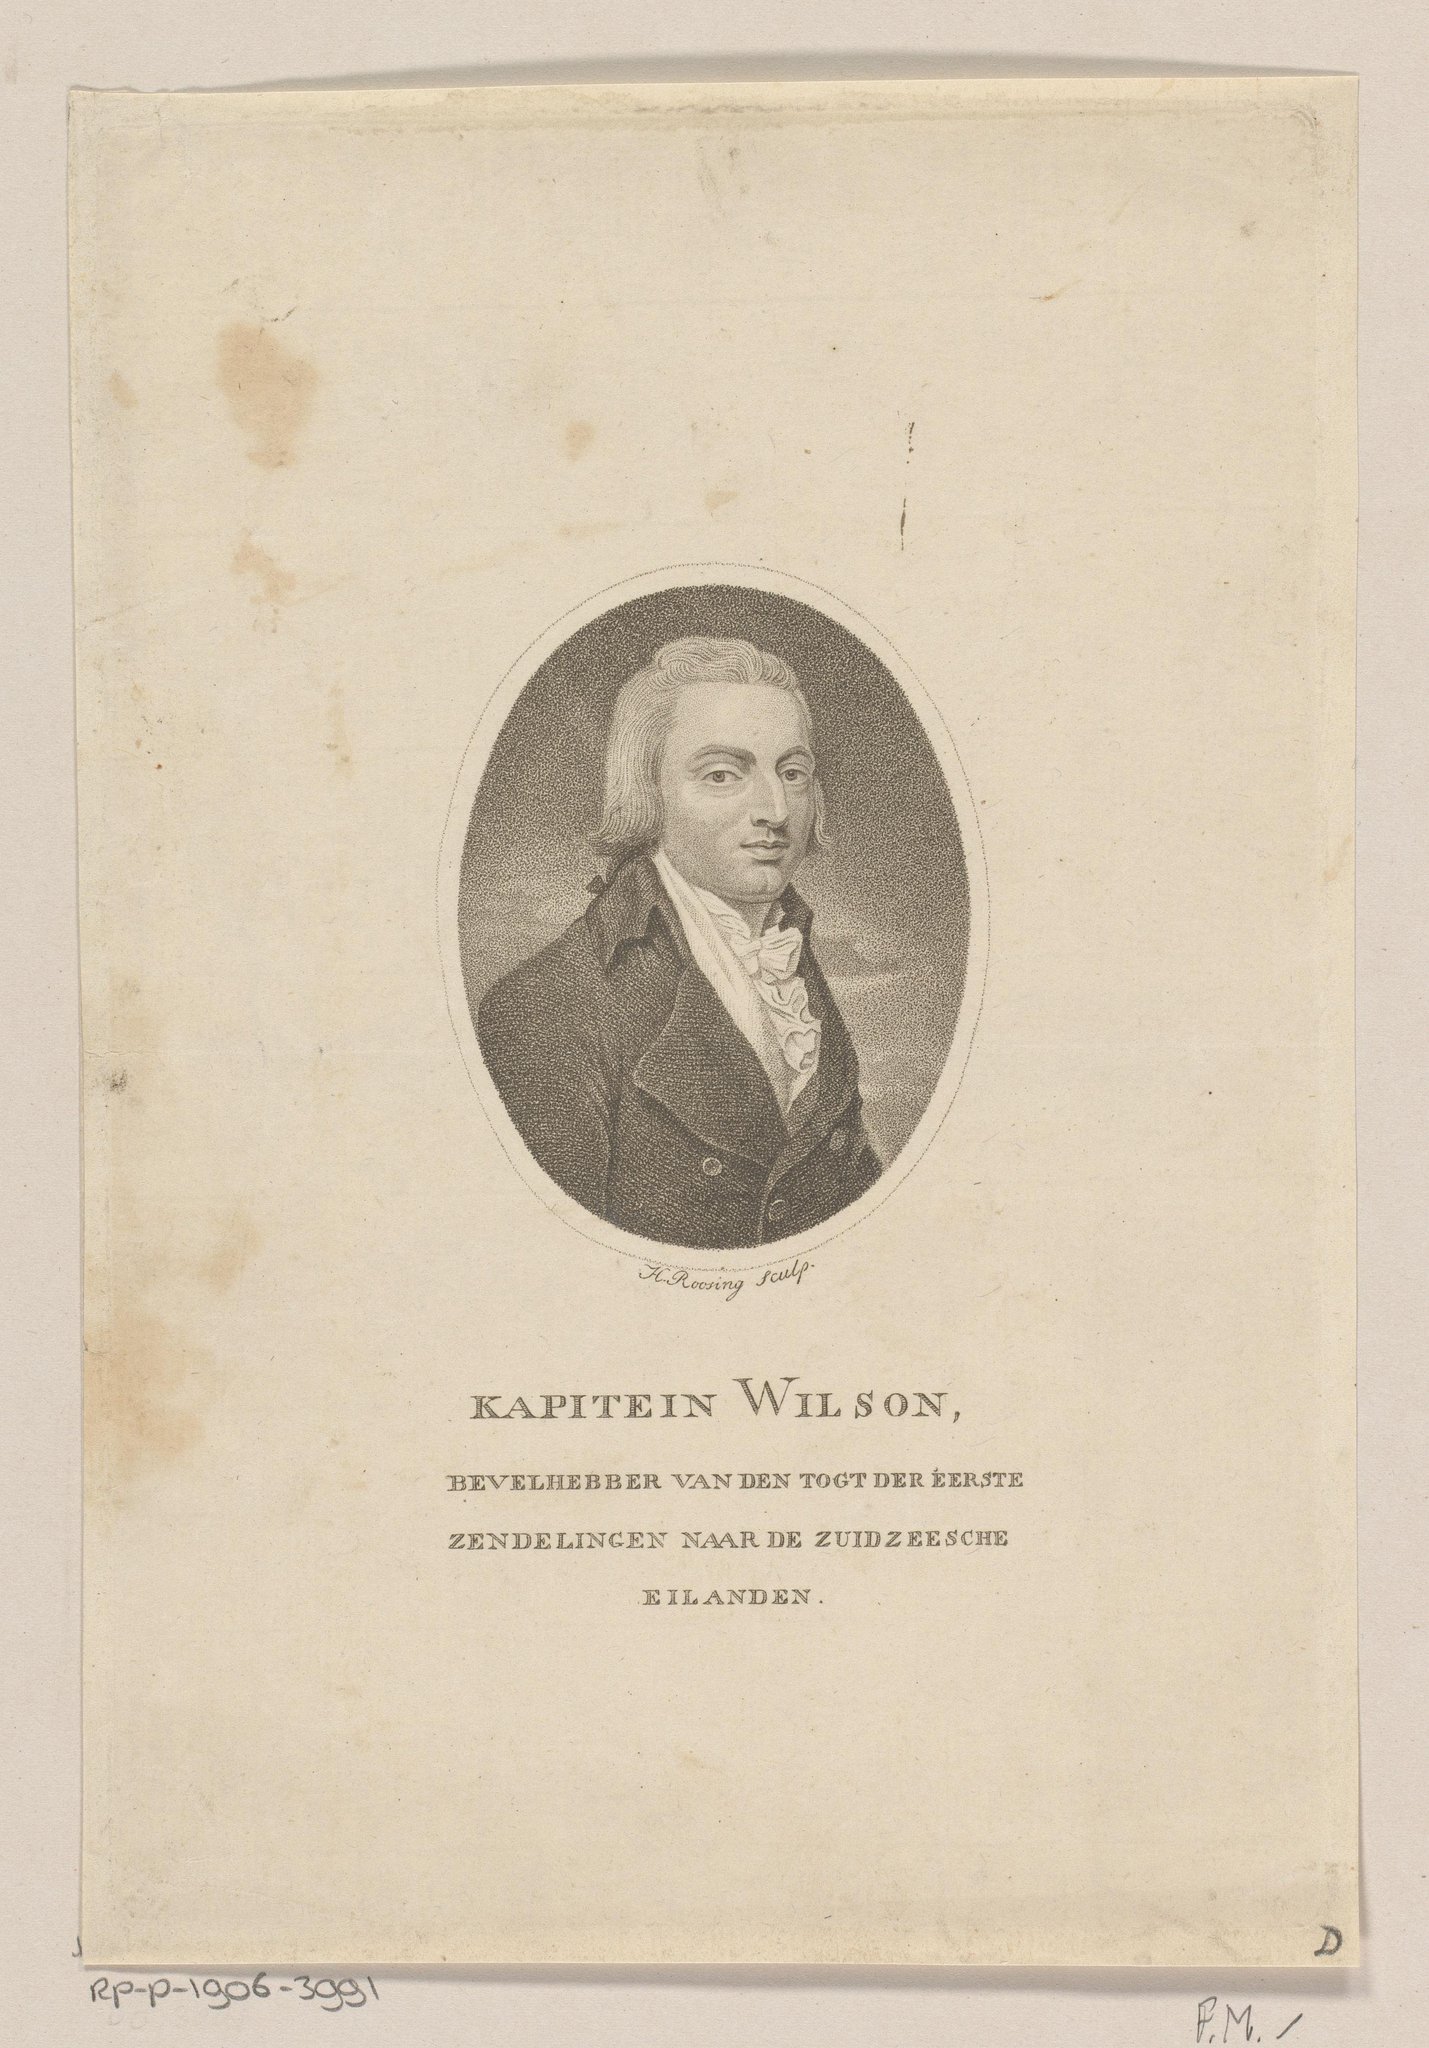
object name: print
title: Portret van Henry Wilson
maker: hendrik roosing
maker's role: print maker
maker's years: 1763-1826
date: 1786-1810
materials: paper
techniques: stippling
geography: rotterdam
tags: historical persons, seaman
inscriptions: collector's mark: Lugt 2228